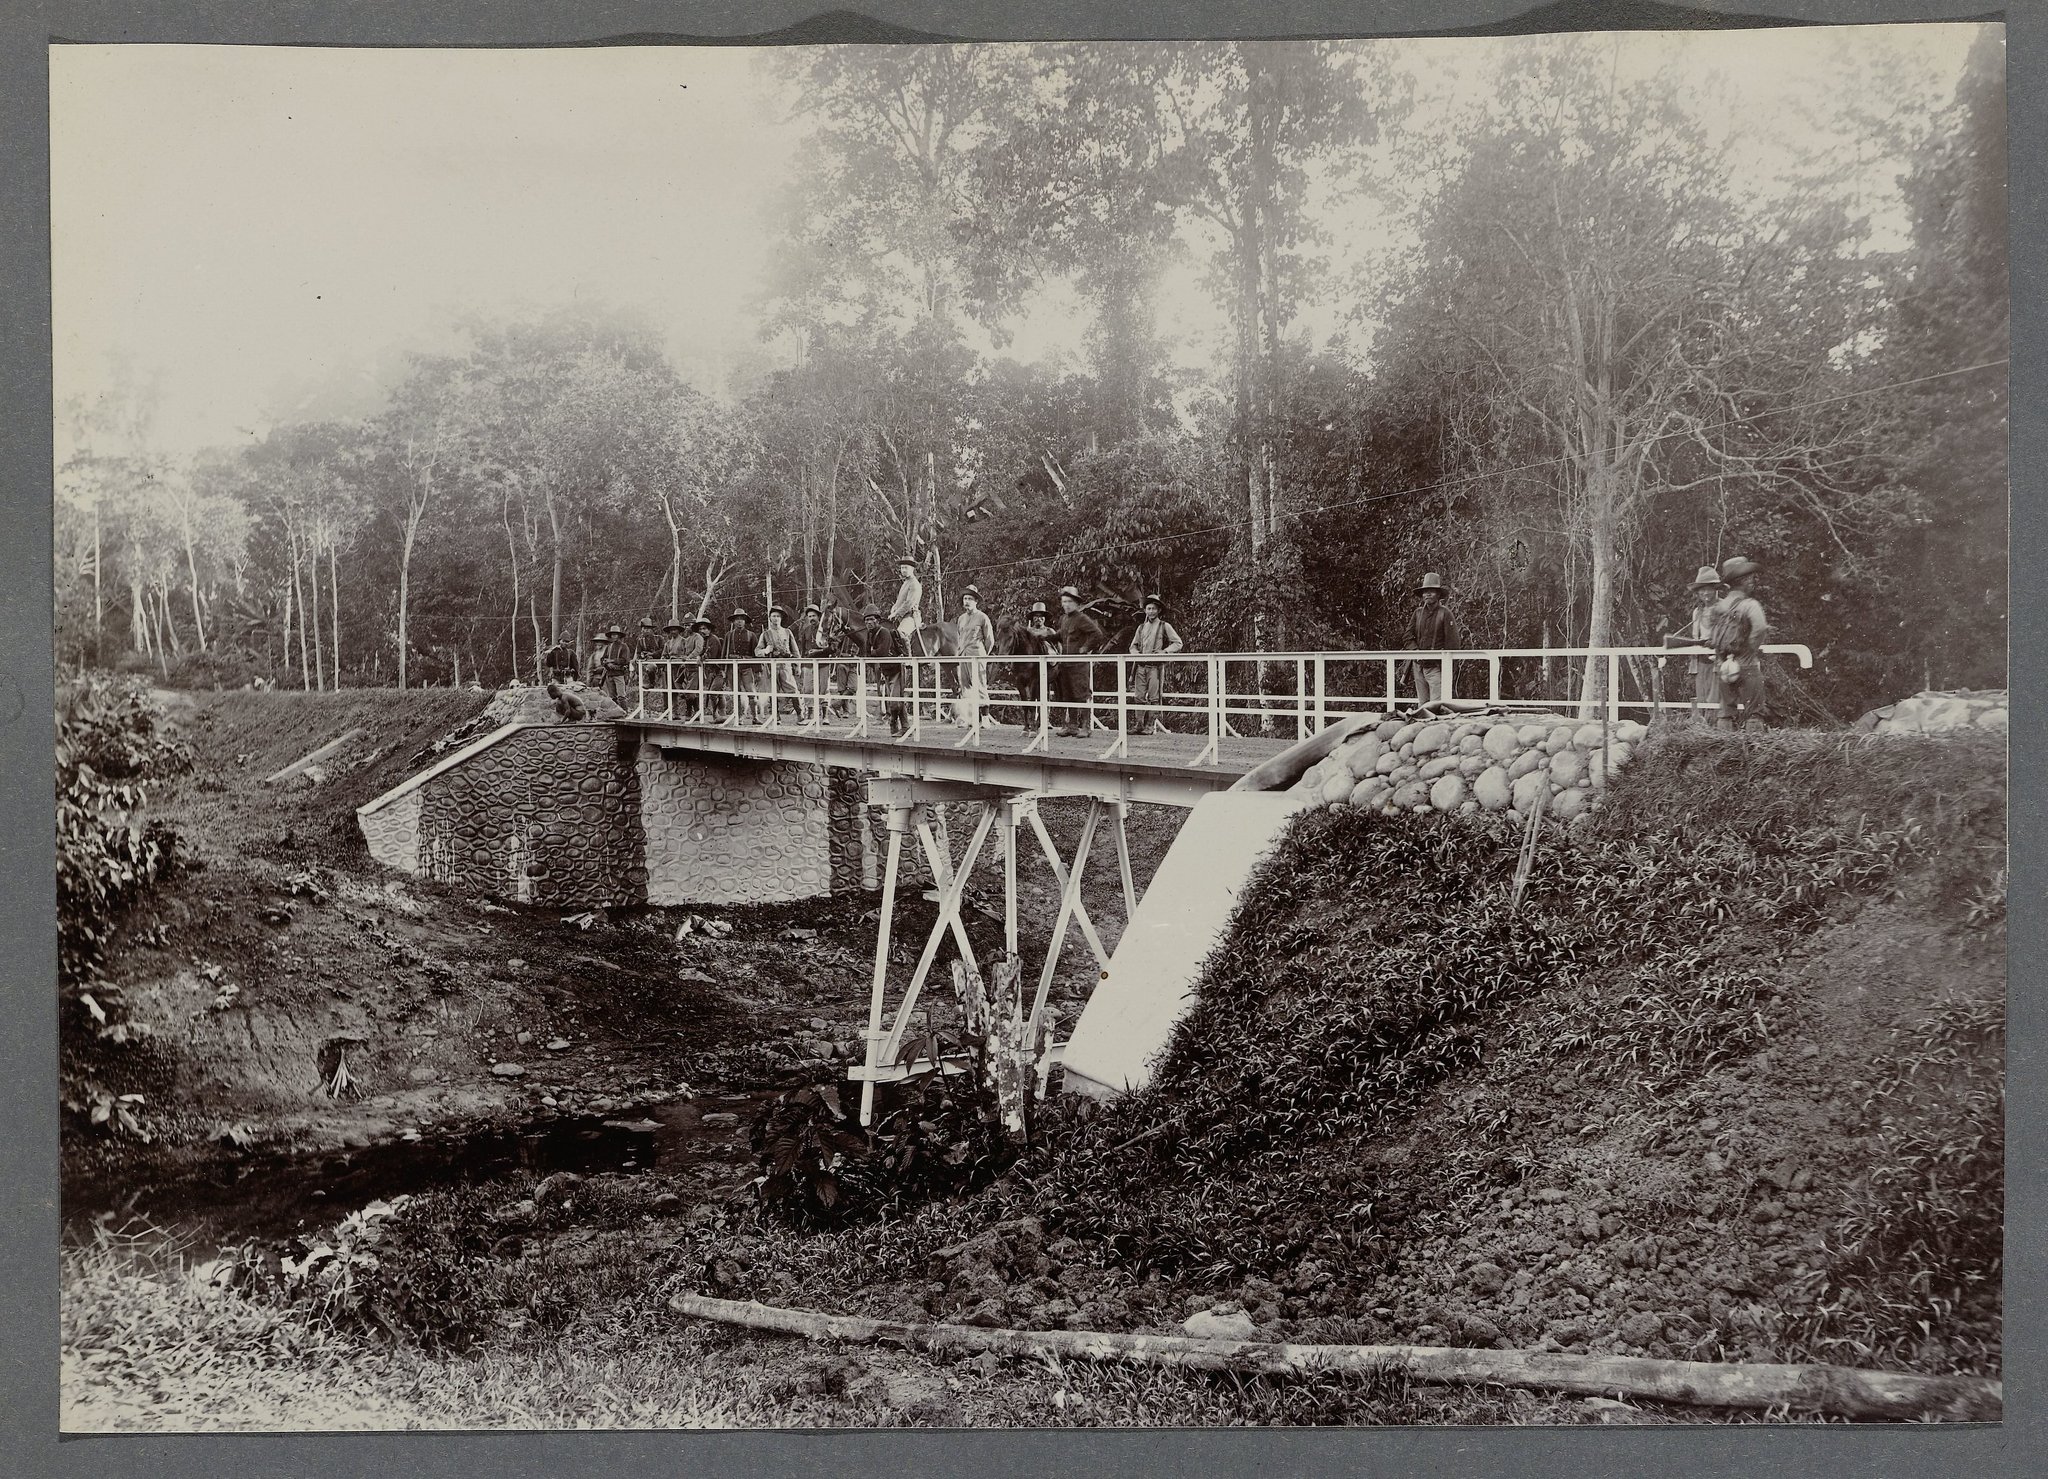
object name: photograph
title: Brug over de rivier Alue Teungoh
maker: Anonymous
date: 1903-1913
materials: photographic support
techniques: gelatin silver print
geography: north sumatra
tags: albertus dominicus laman trip, building activities, traffic by road or path with motor-vehicle, landscapes in tropical and sub-tropical regions, road, path, bridge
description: Na de expedities naar de Gajo- en Alaslanden o.l.v. Van Daalen (eerste tocht in 1901), werd hij in 1903 belast met voorbereiding van permanente vestiging van Nederlands gezag. Aanleg van een weg van de Noordkust naar het binnenland was hierbij van groot belang. Deze zgn. Gajoweg werd aangelegd tussen 1903 en 1914, van Bireuen aan de kust naar Takinguen aan het bergmeer Danau Lauttawar, totale lengte 104 km.